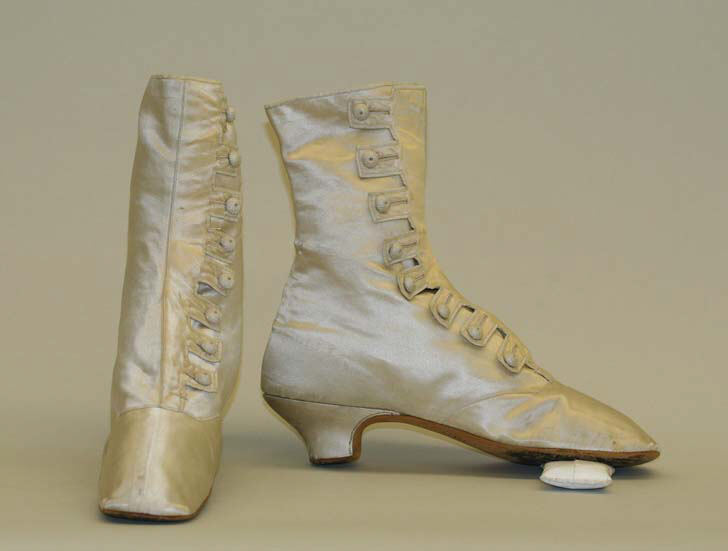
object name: wedding boot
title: Wedding boots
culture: american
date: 1870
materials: leather, silk, wood